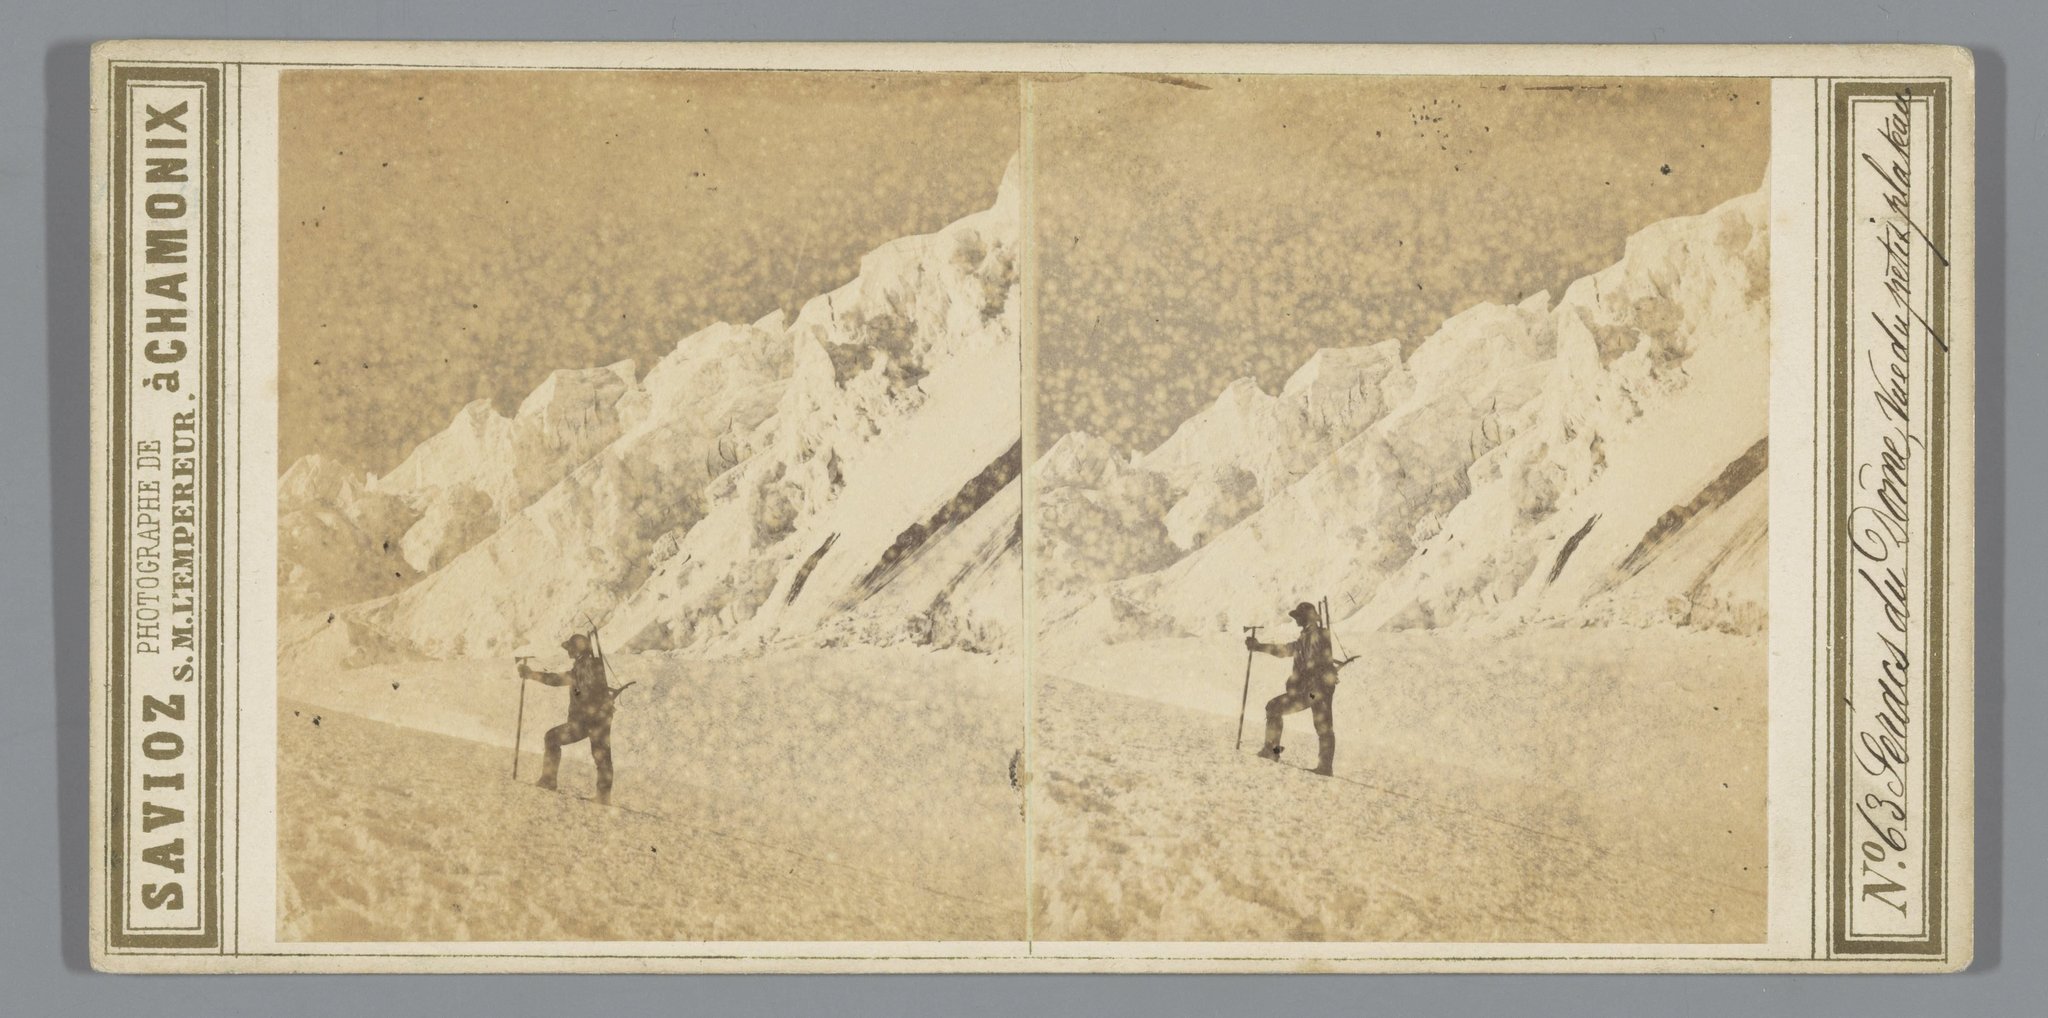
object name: stereograph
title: Bergbeklimmer op de seracs nabij het Petit Plateau van de Dôme du Goûter, Mont Blanc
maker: eugène savioz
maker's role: fotograaf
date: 1867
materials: cardboard, paper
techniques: albumen print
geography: dome du goûter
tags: mountain climbing, mountaineering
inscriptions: number: ‘No. 63’